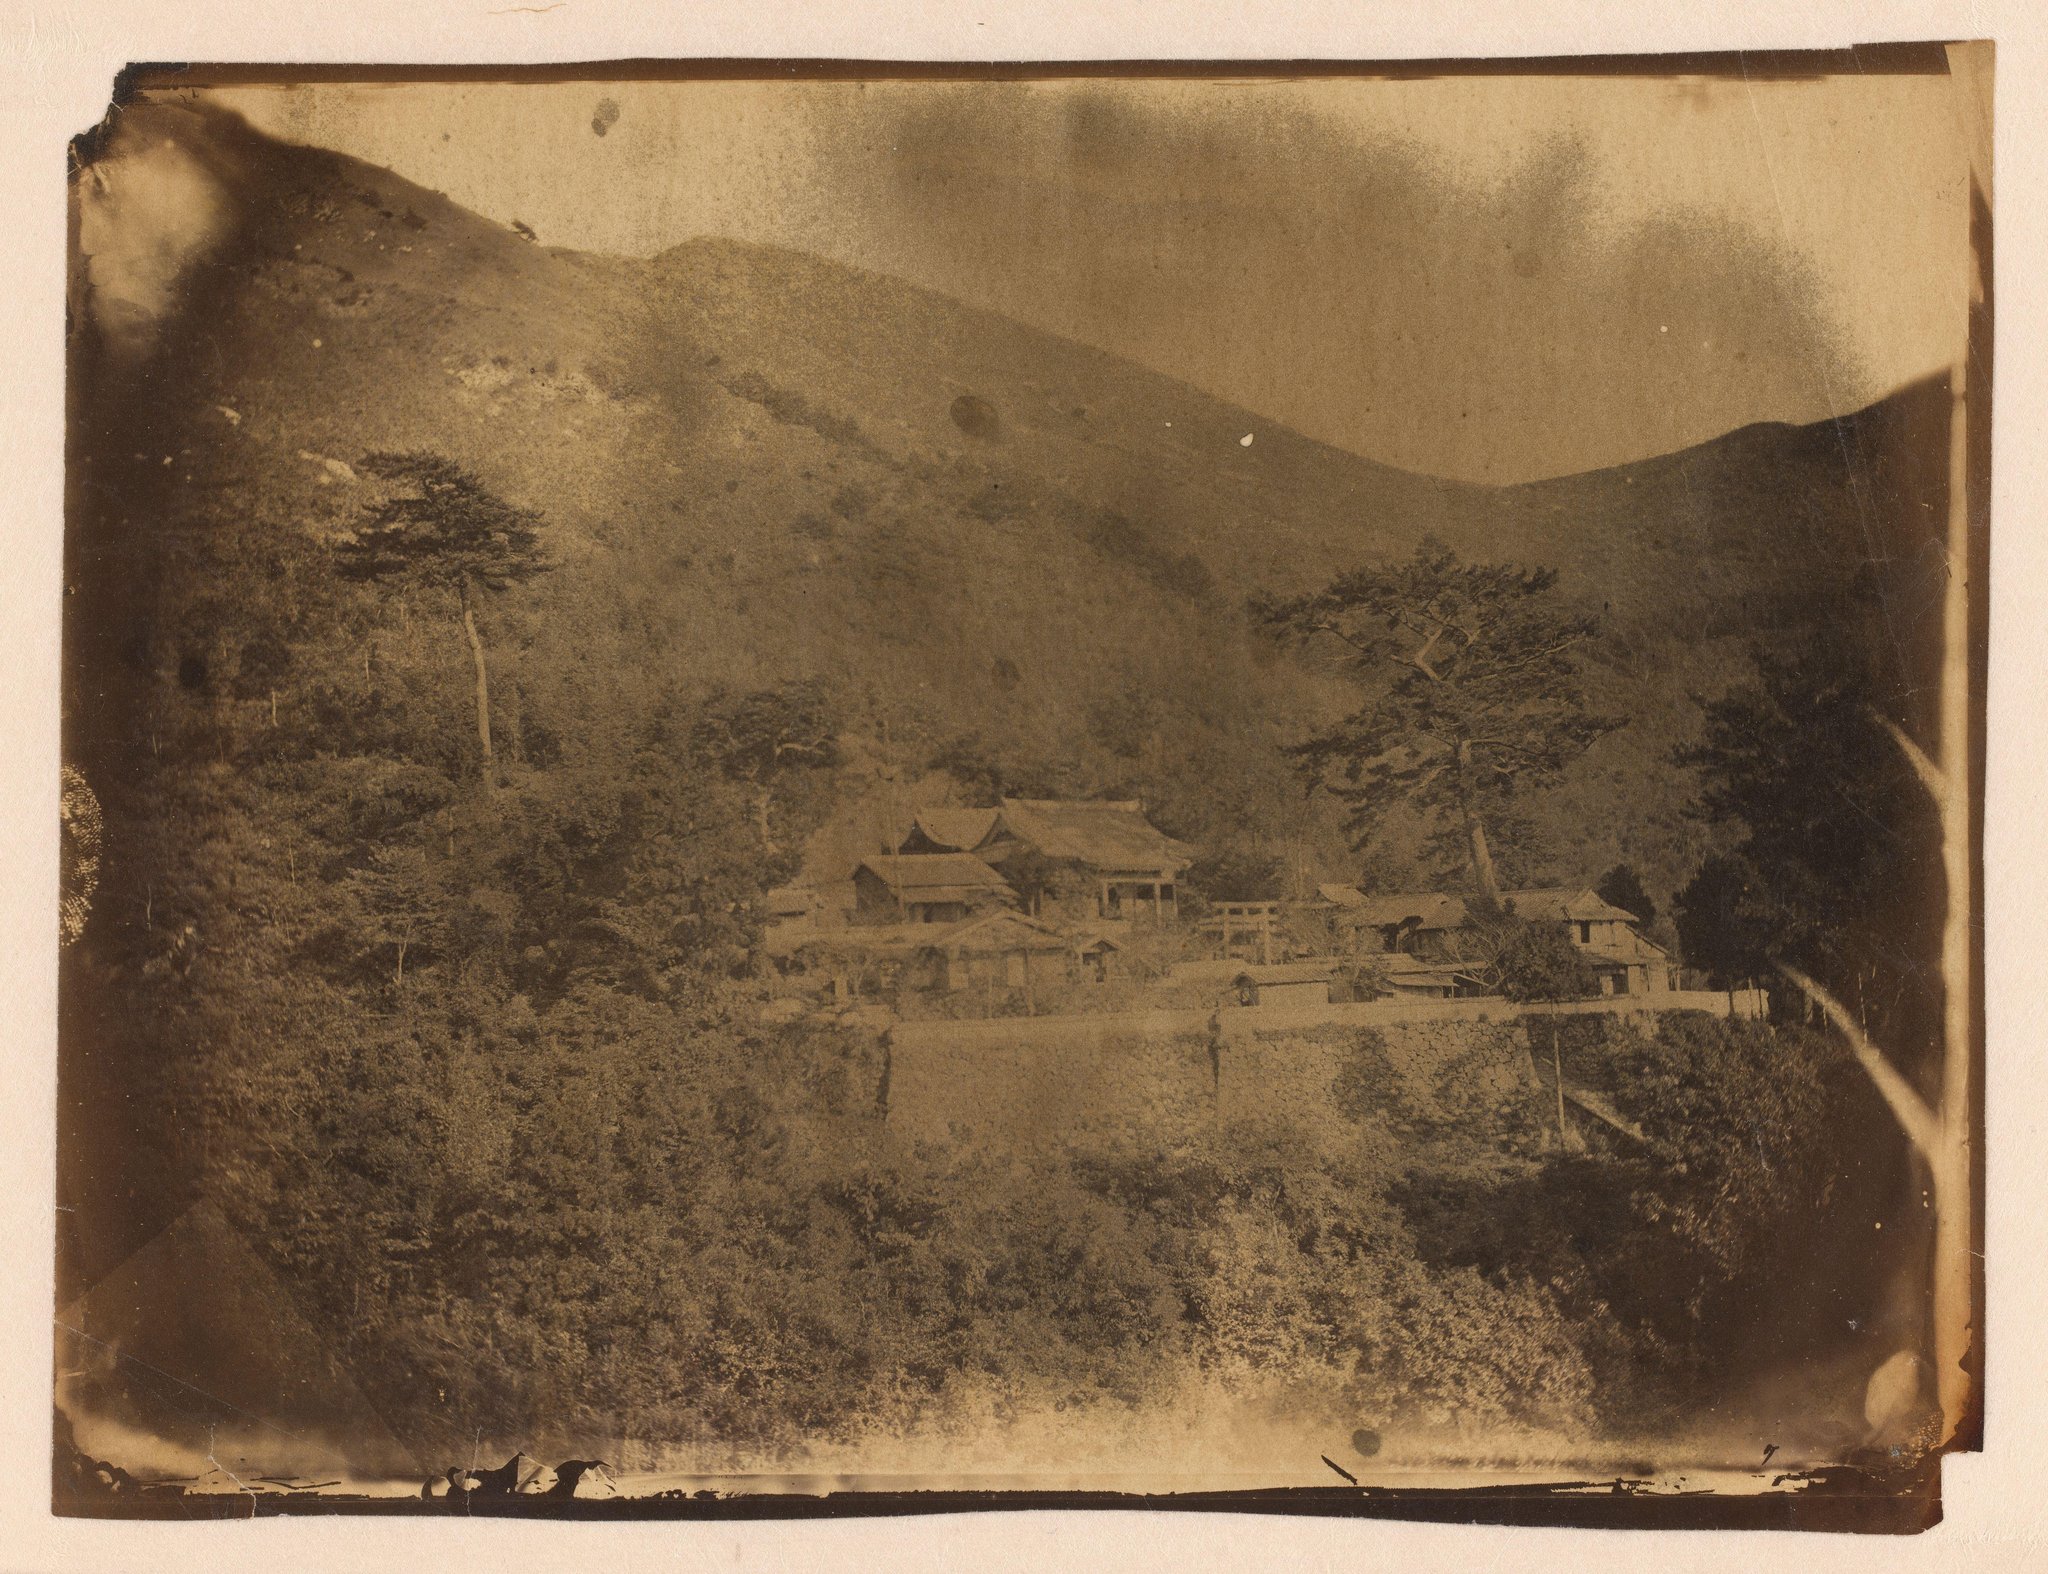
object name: photograph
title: Dorp in de bergen van Japan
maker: antoon bauduin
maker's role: amateurfotograaf, hoogleraar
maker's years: 1820-1885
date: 1862-1866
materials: paper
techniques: albumen print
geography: japan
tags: prospect of village, silhouette of village, japan